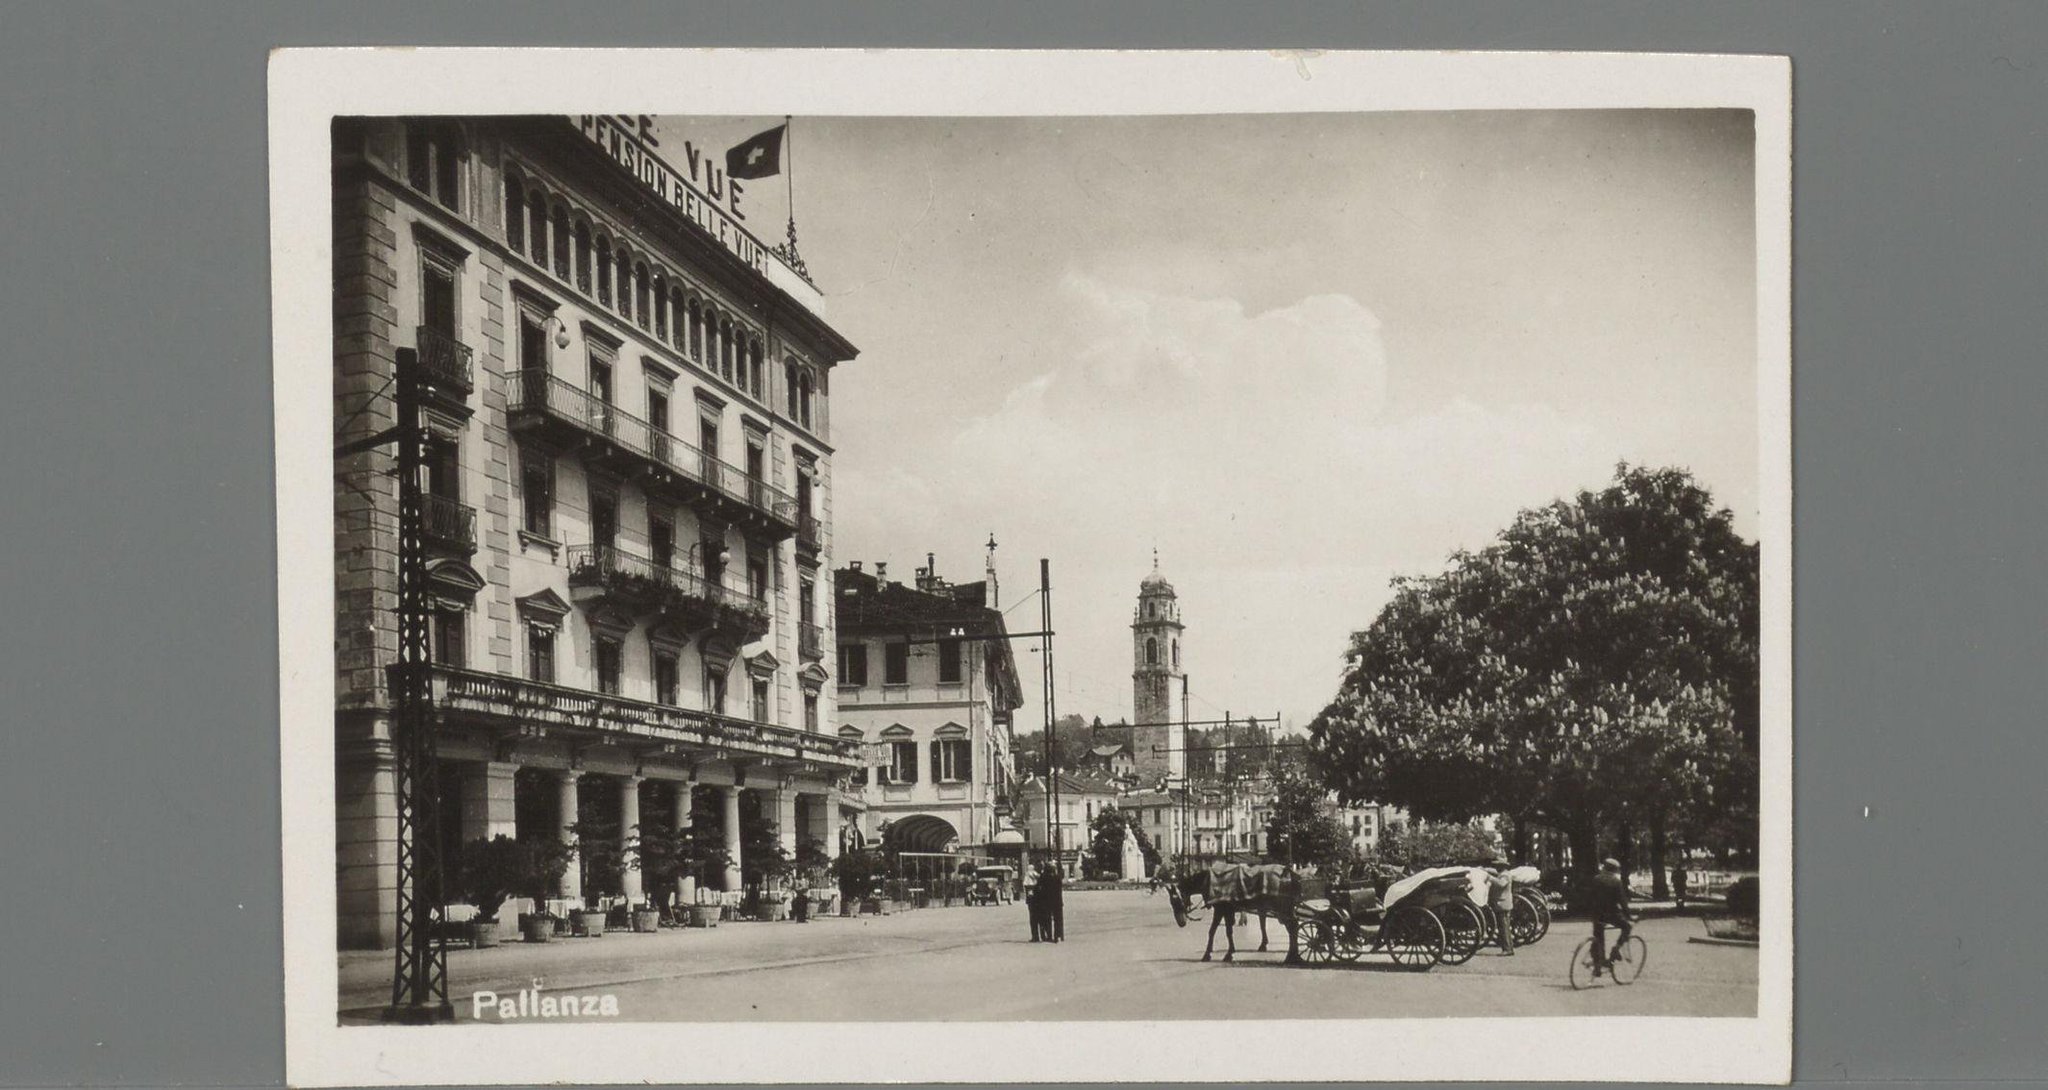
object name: photograph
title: Pallanza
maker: Anonymous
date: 1904-1935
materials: photographic support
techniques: photography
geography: pallanza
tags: four-wheeled, animal-drawn vehicle, e.g.: cab, carriage, coach, city-view, and landscape with man-made constructions (+ city(-scape) with figures, staffage)